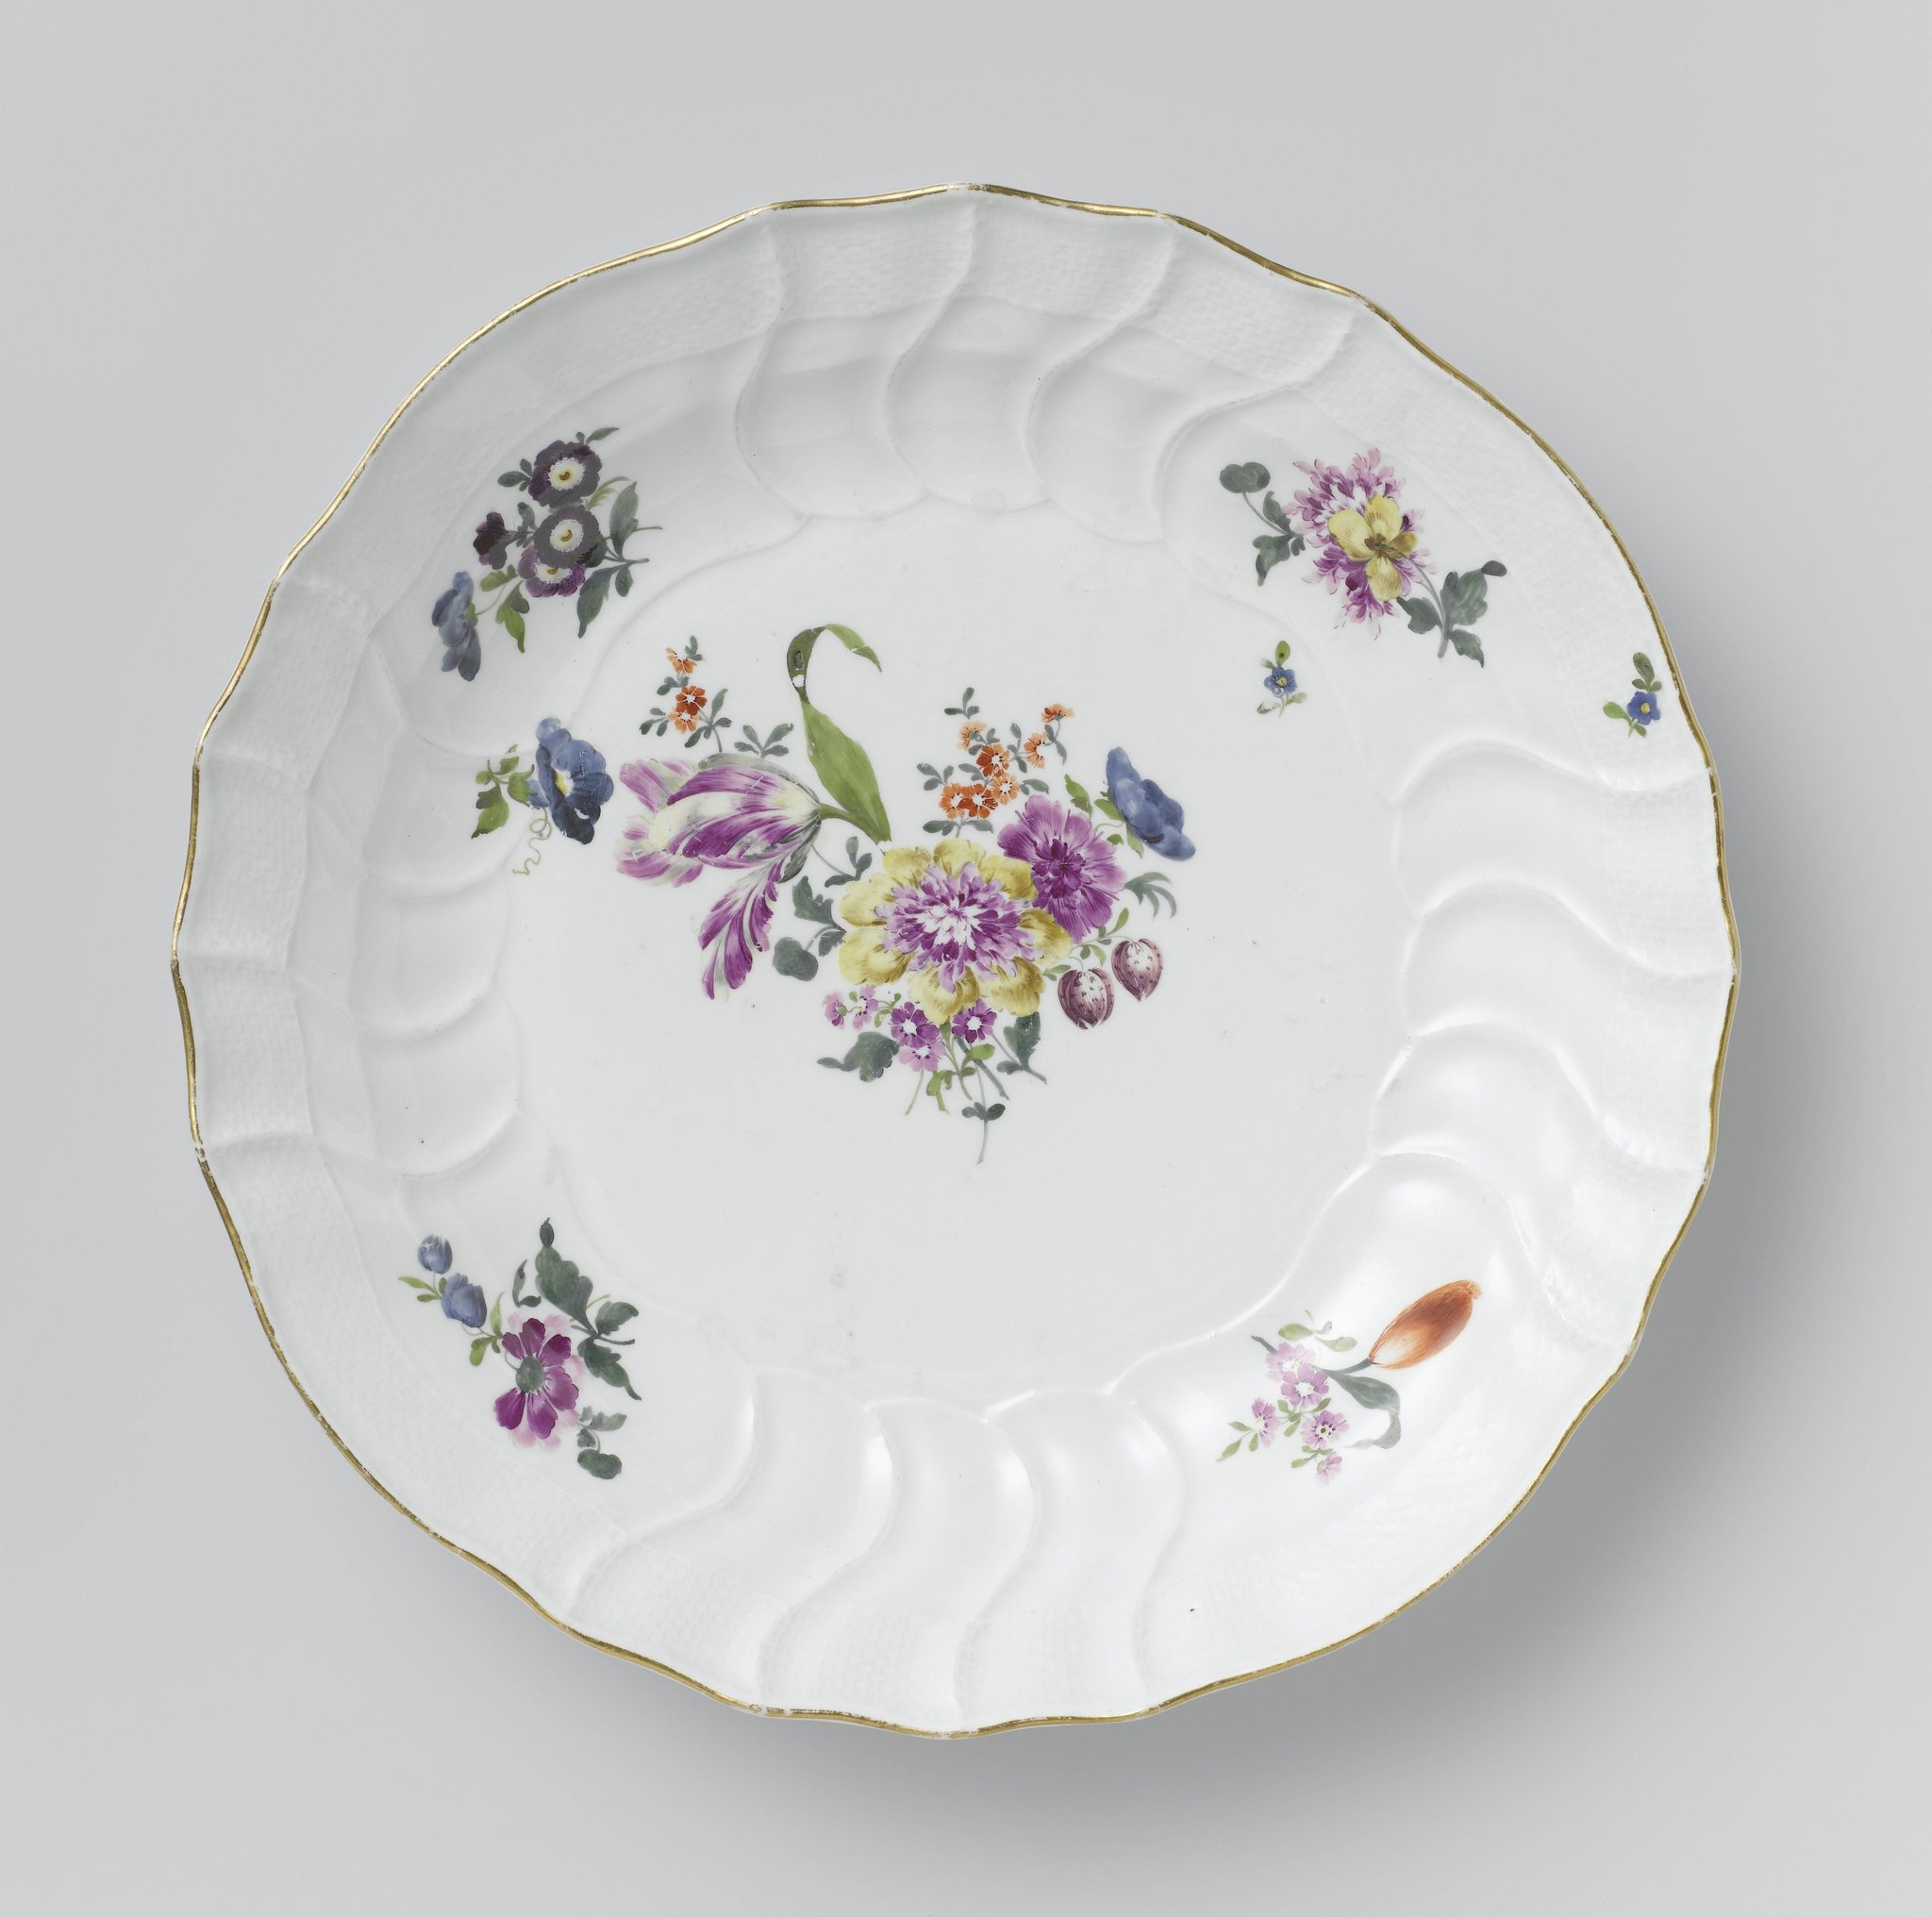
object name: platter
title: Schotel, veelkleurig beschilderd met Deutsche Blumen, insekten en vruchten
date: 1750-1760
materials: porcelain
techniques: painted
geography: meissen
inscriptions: factory mark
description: Ronde schotel van beschilderd porselein. De schotel is beschilderd met Deutsche Blumen, insekten en vruchten. De rand is in reliëf versierd met het Neuozier-patroon. De schotel is gemerkt en hoort bij een servies (BK-17474-1 t/m BK-17474-253).